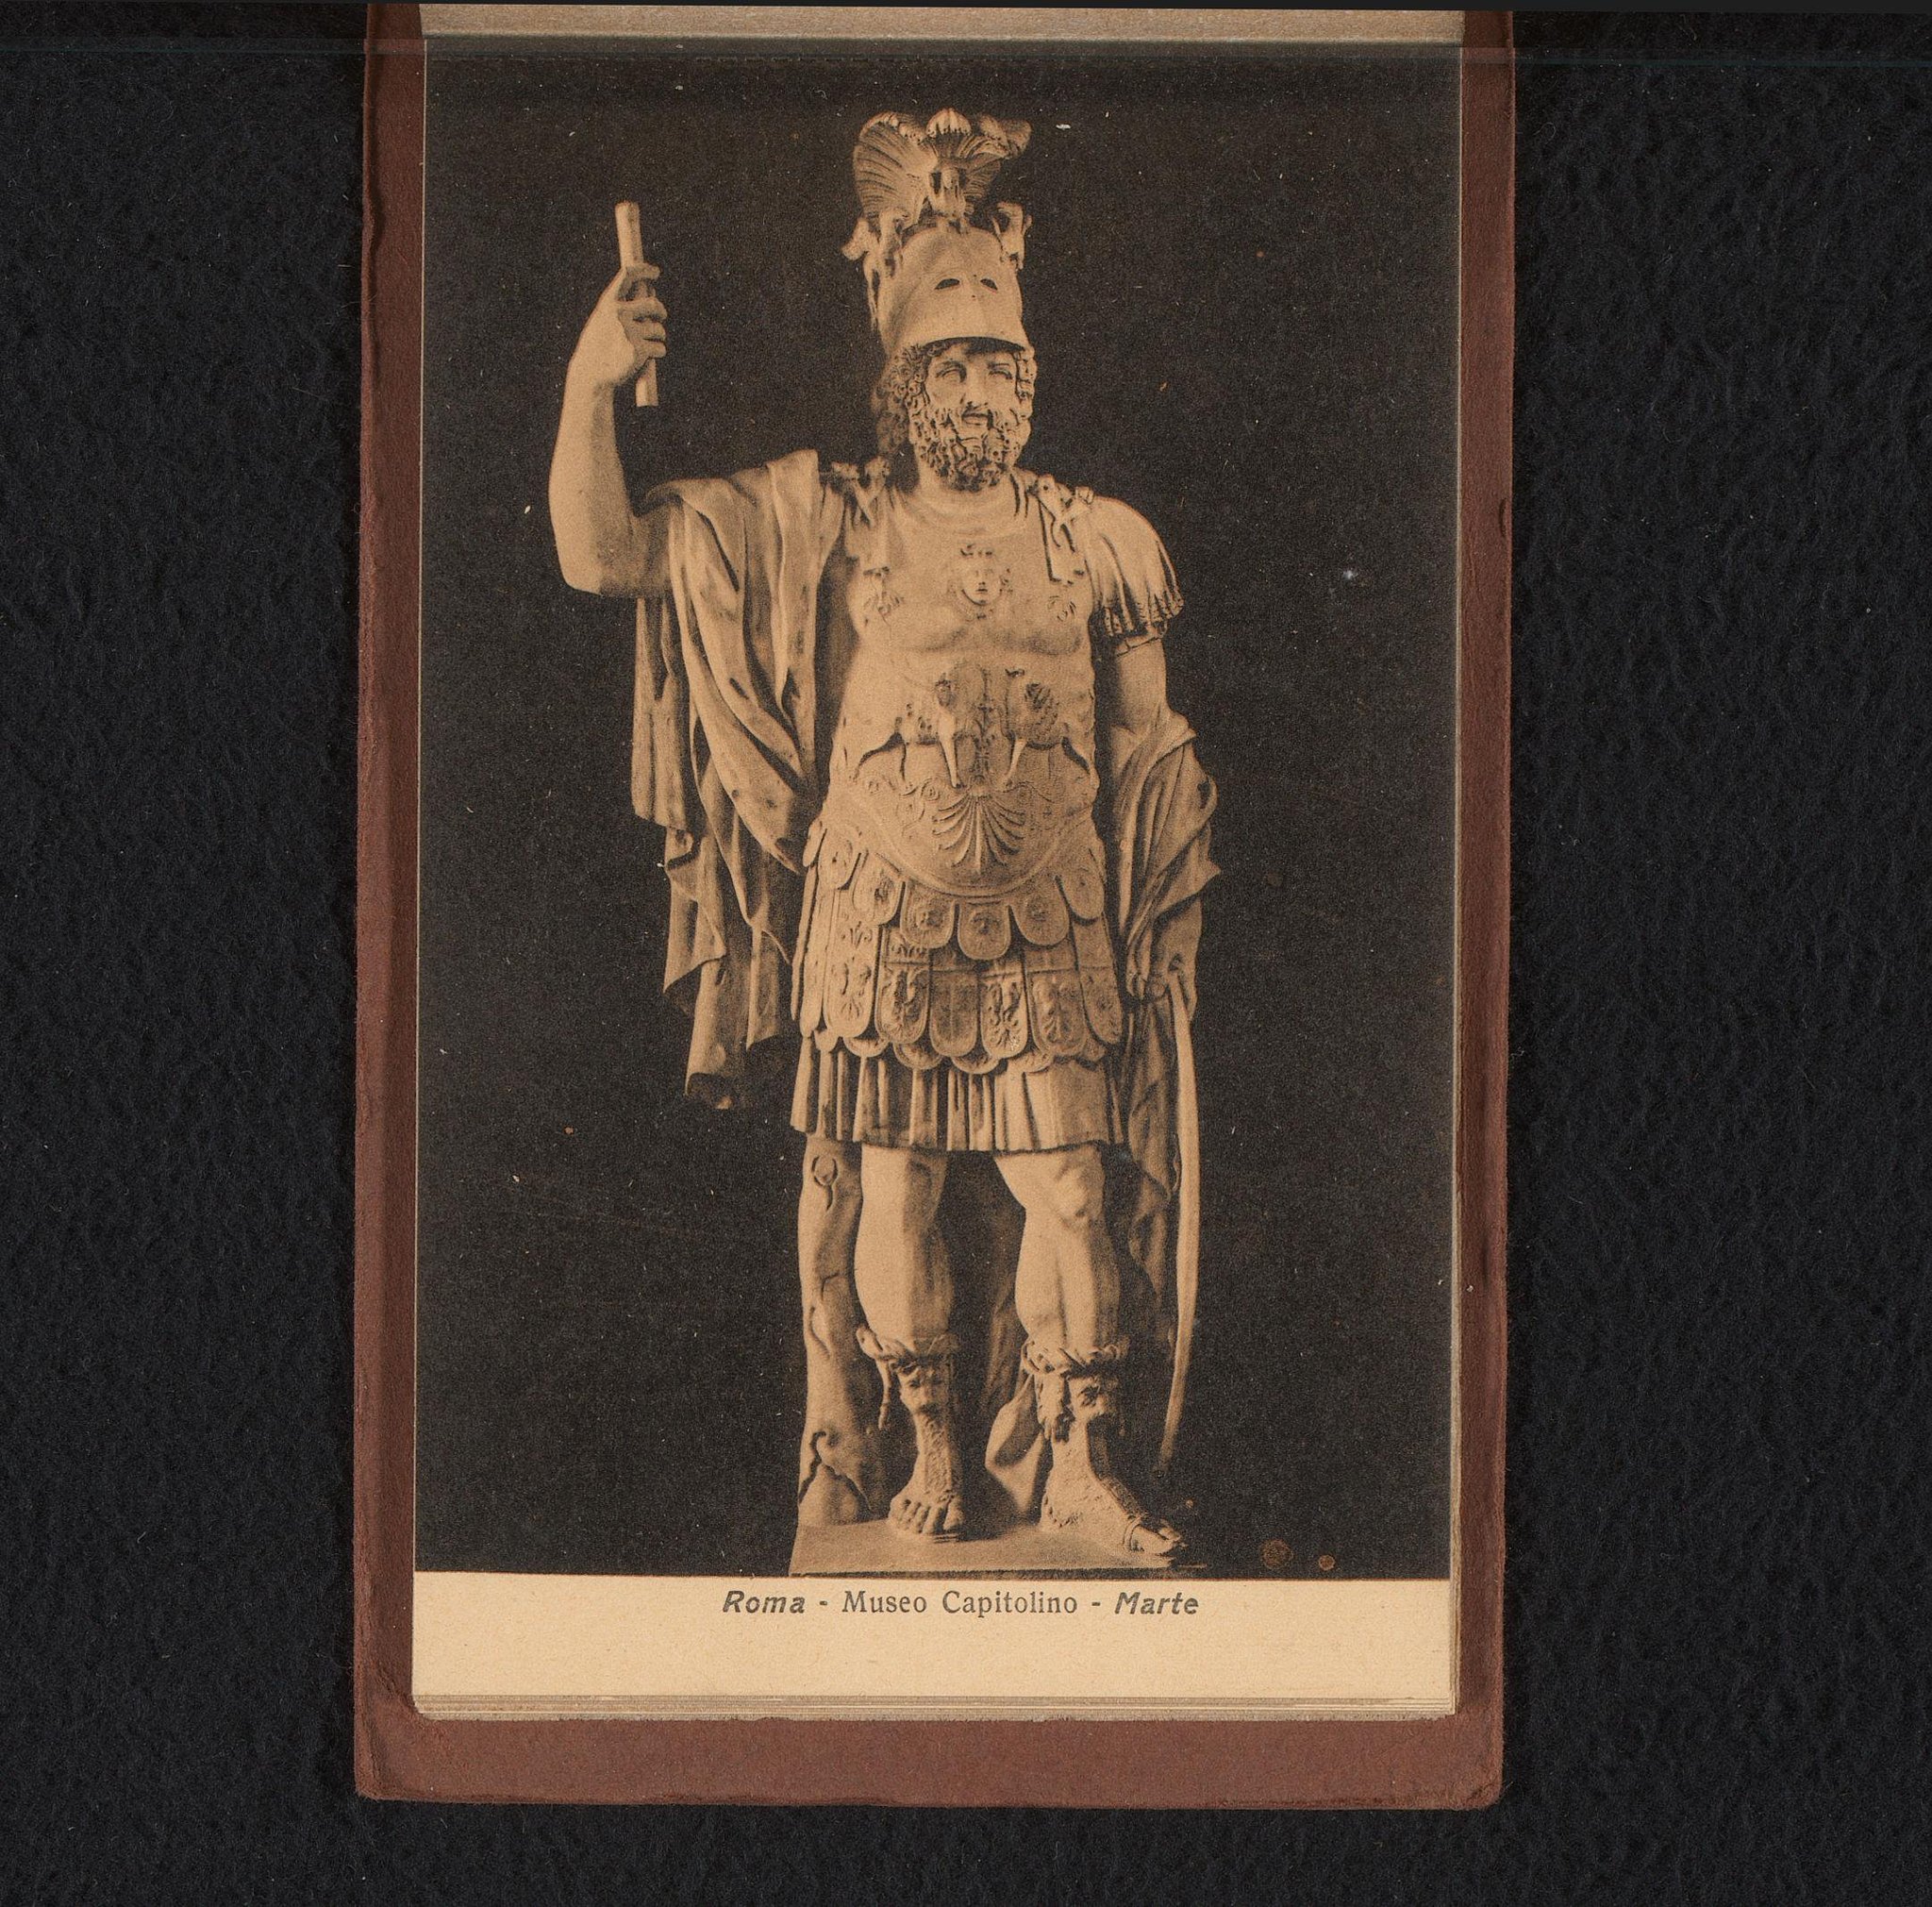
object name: photomechanical print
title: Roma - Museo Capitolino - Marte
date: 1905-1930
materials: cardboard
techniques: photograph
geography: terni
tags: statues, paintings, etc. ~ objects of worship in roman religion, permanent exhibition, museum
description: Prentbriefkaart maakt deel uit van een album.